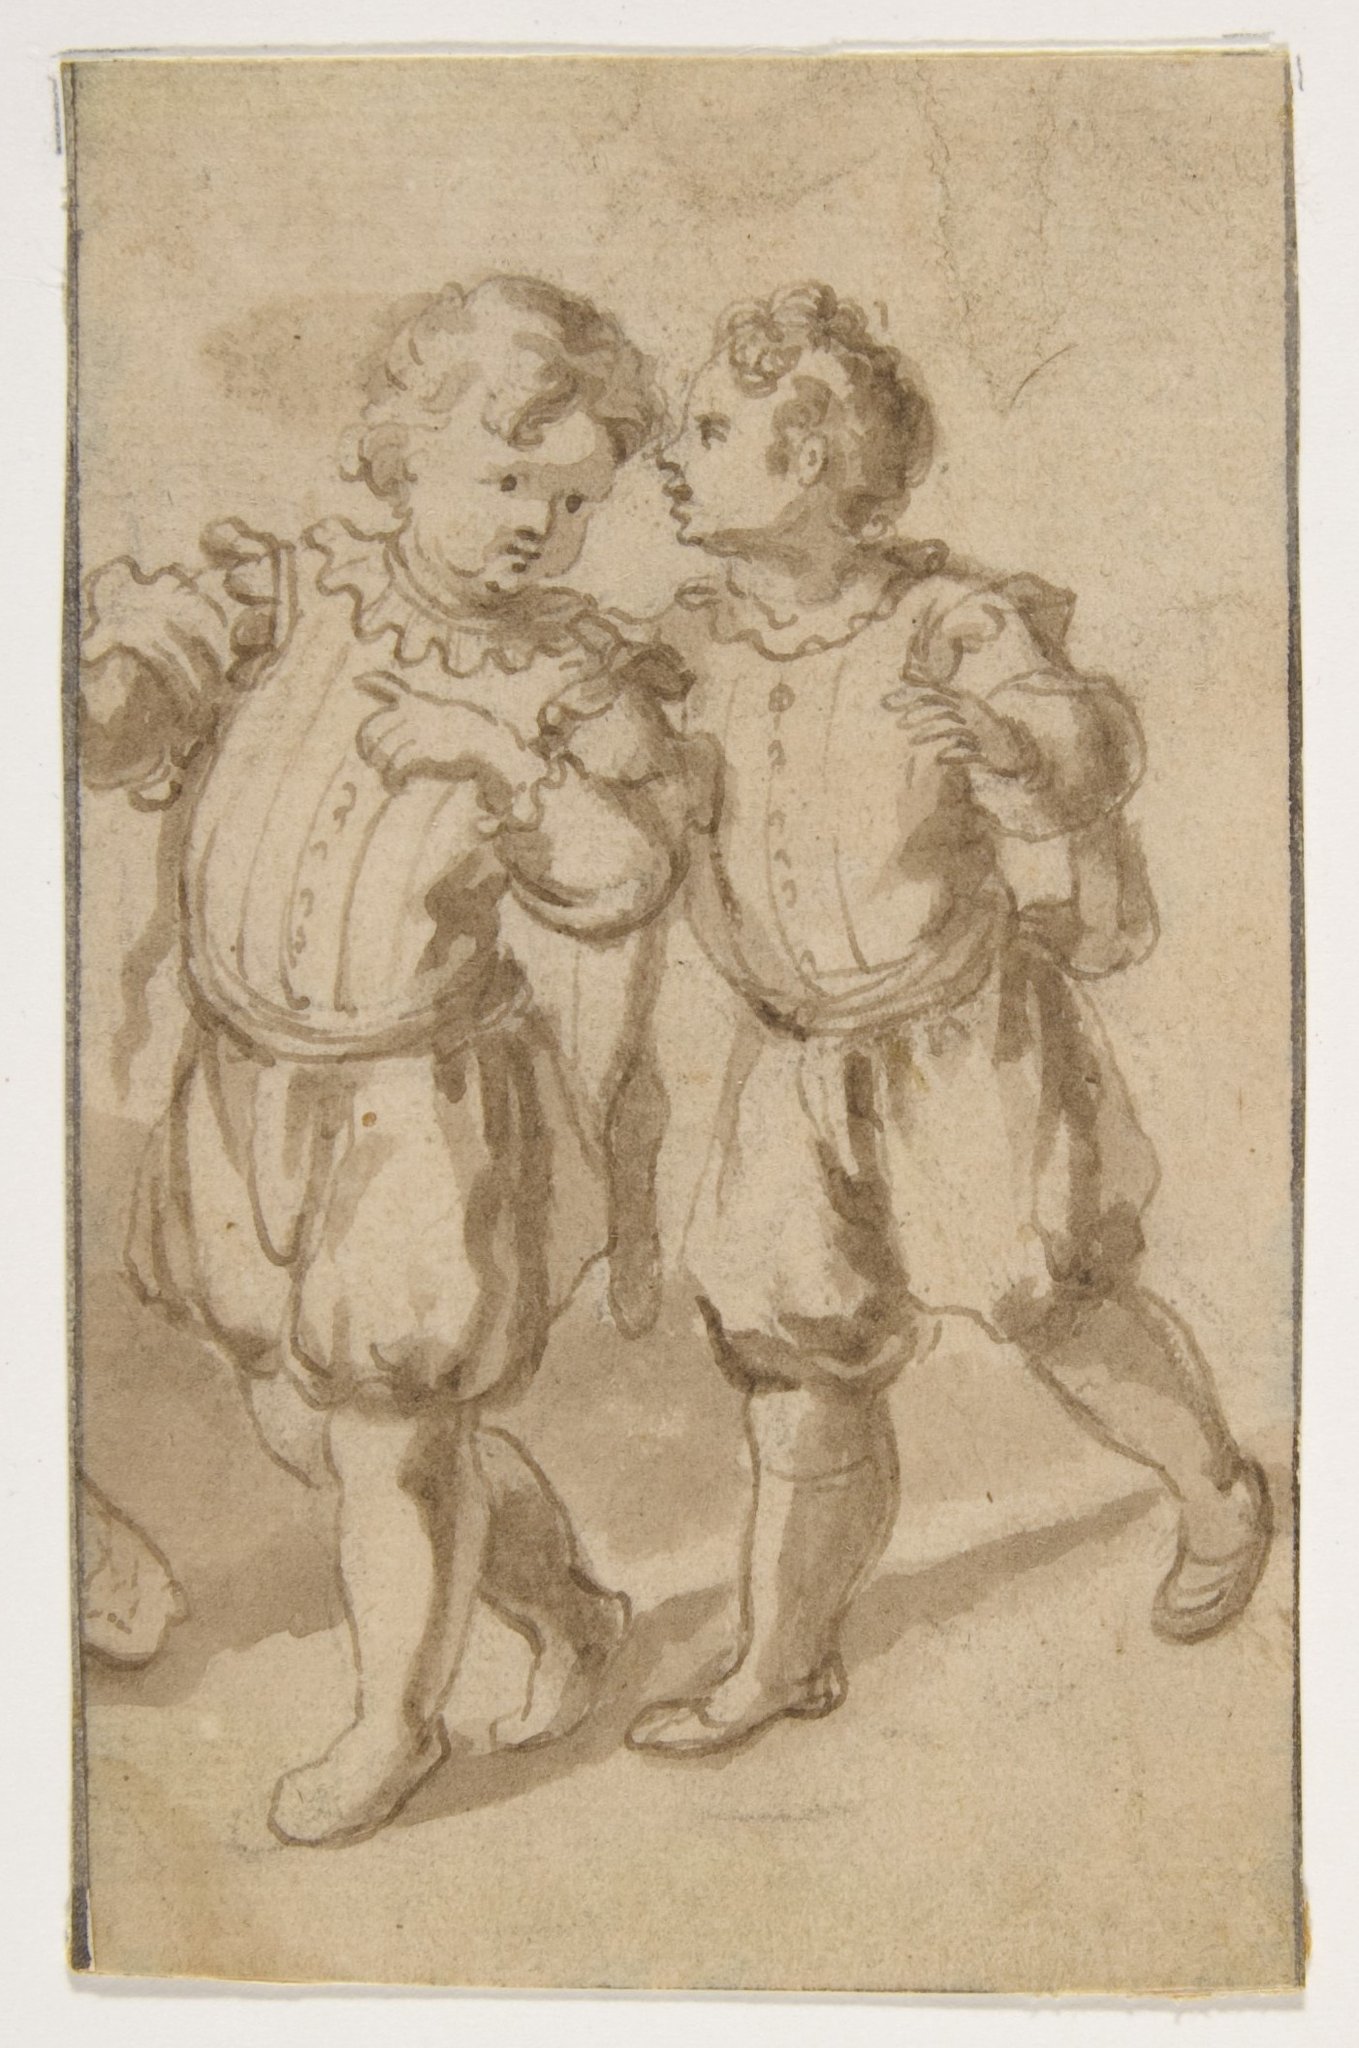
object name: drawing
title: Two Young Page-Boys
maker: bernardino rodriguez ("bernardino siciliano")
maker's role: artist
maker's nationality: italian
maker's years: 1600-1650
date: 1600-1650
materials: ink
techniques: brush, pen, wash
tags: boys